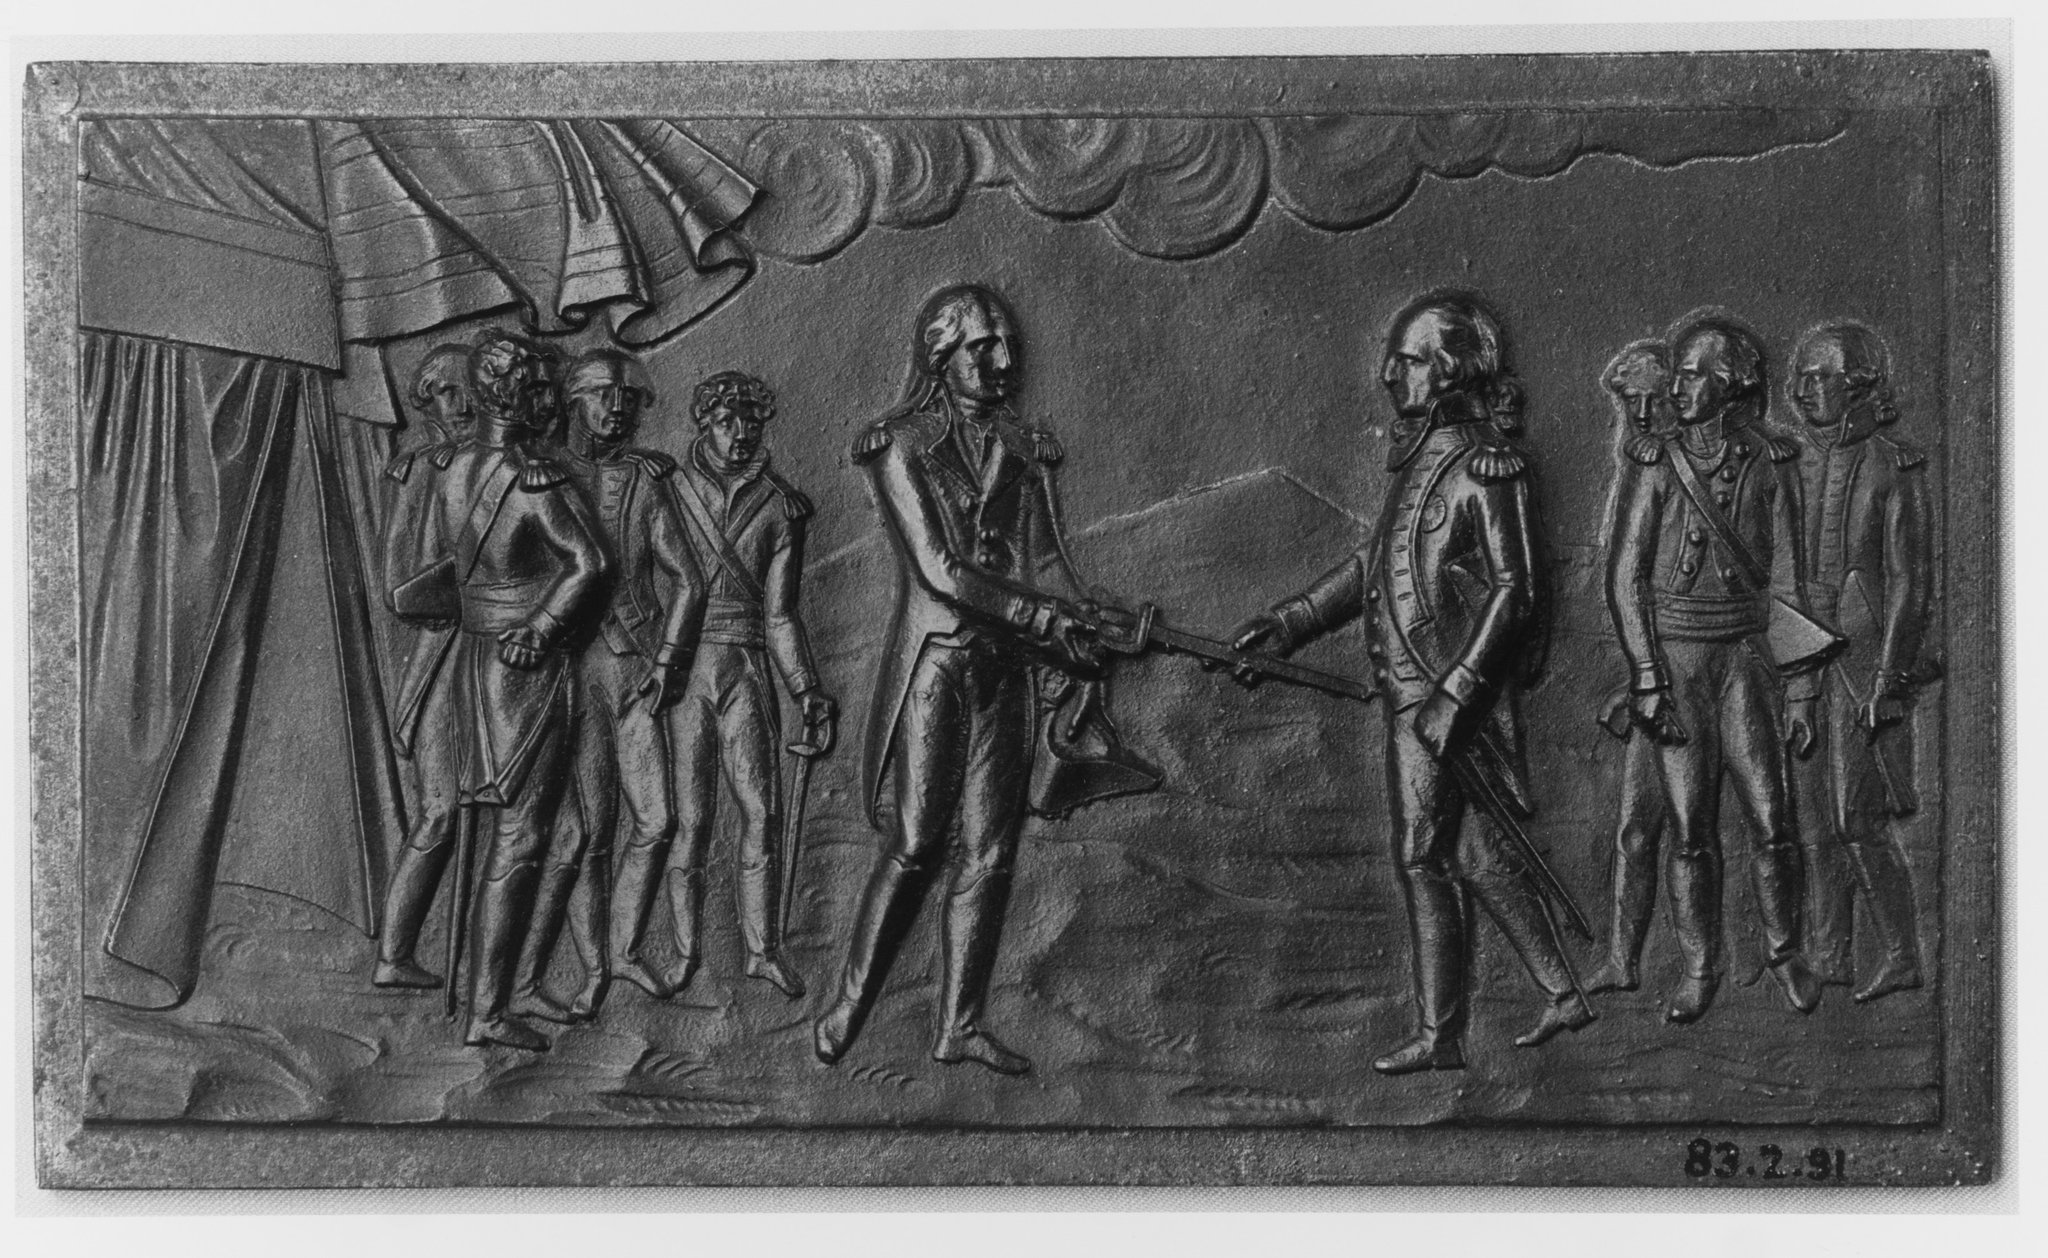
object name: plaque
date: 1781-1783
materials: iron, steel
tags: swords,men